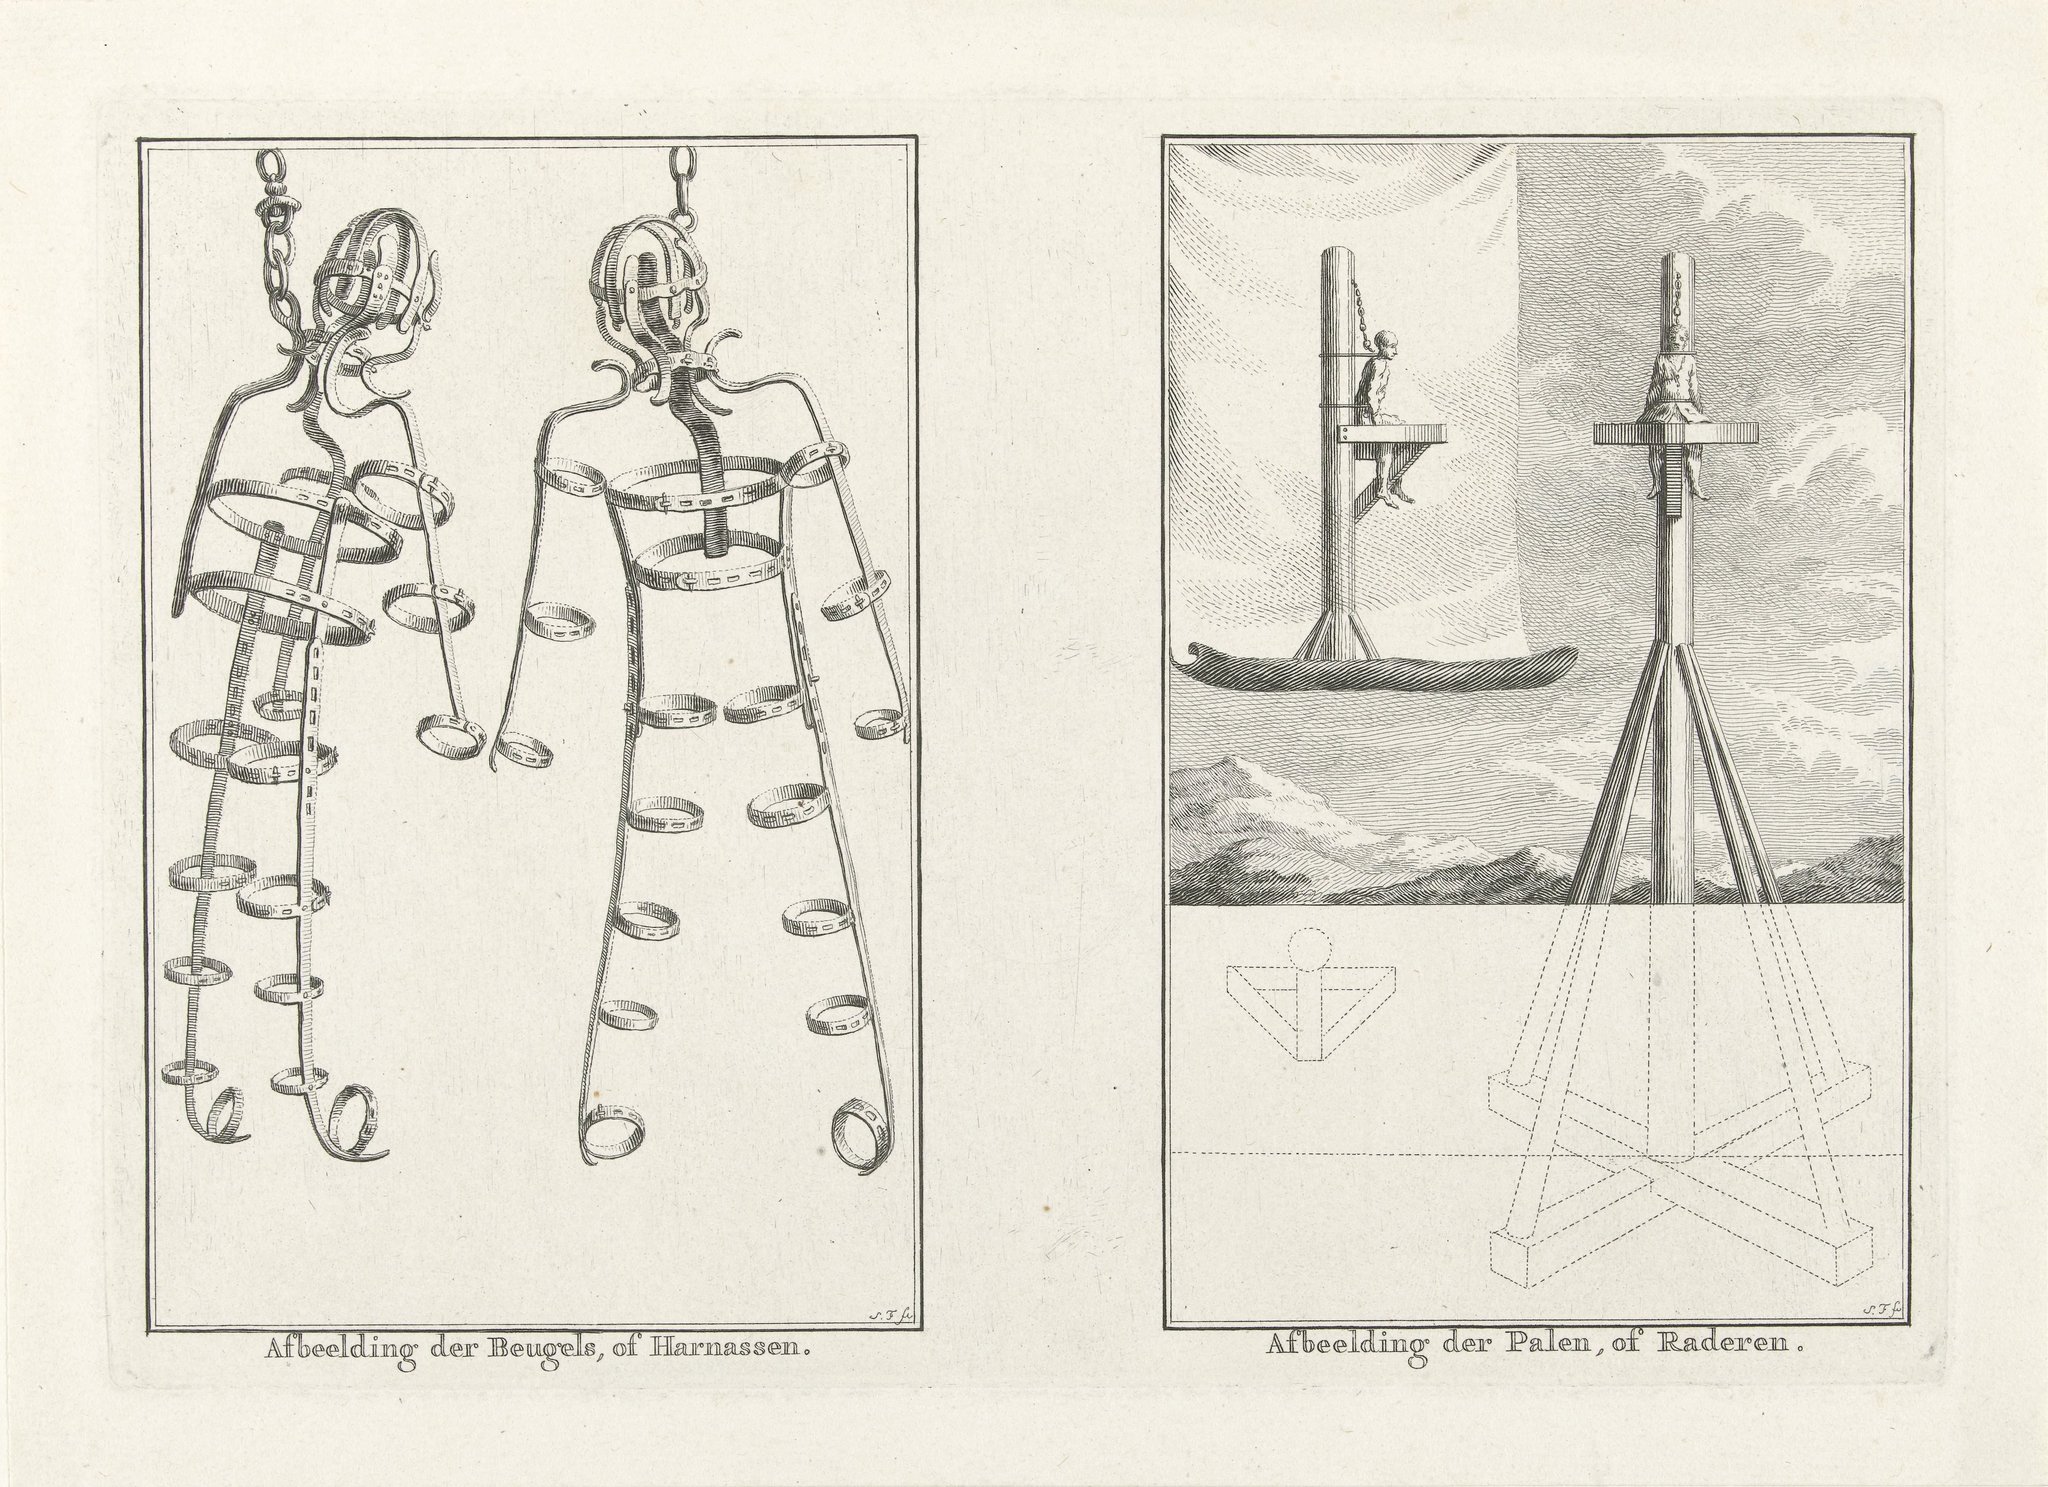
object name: print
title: Afbeelding der Beugels, of Harnassen / Afbeelding der Palen, of Raderen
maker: simon fokke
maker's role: draughtsman, print maker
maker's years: 1712-1784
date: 1764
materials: paper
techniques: engraving, etching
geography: northern netherlands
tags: instruments of torture, execution or punishment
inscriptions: collector's mark: Lugt 2228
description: Blad met twee voorstellingen van de werktuigen waarmee de lichamen van de ter dood gebrachte muiters van het koopvaardijschip genaamd de Nijenburg in de duinen bij Huisduinen ten toon werden gesteld, september 1764. Links een soort harnas waarin het lichaam met riemen gebonden, rechts een paal waarop het lichaam werd gebonden.